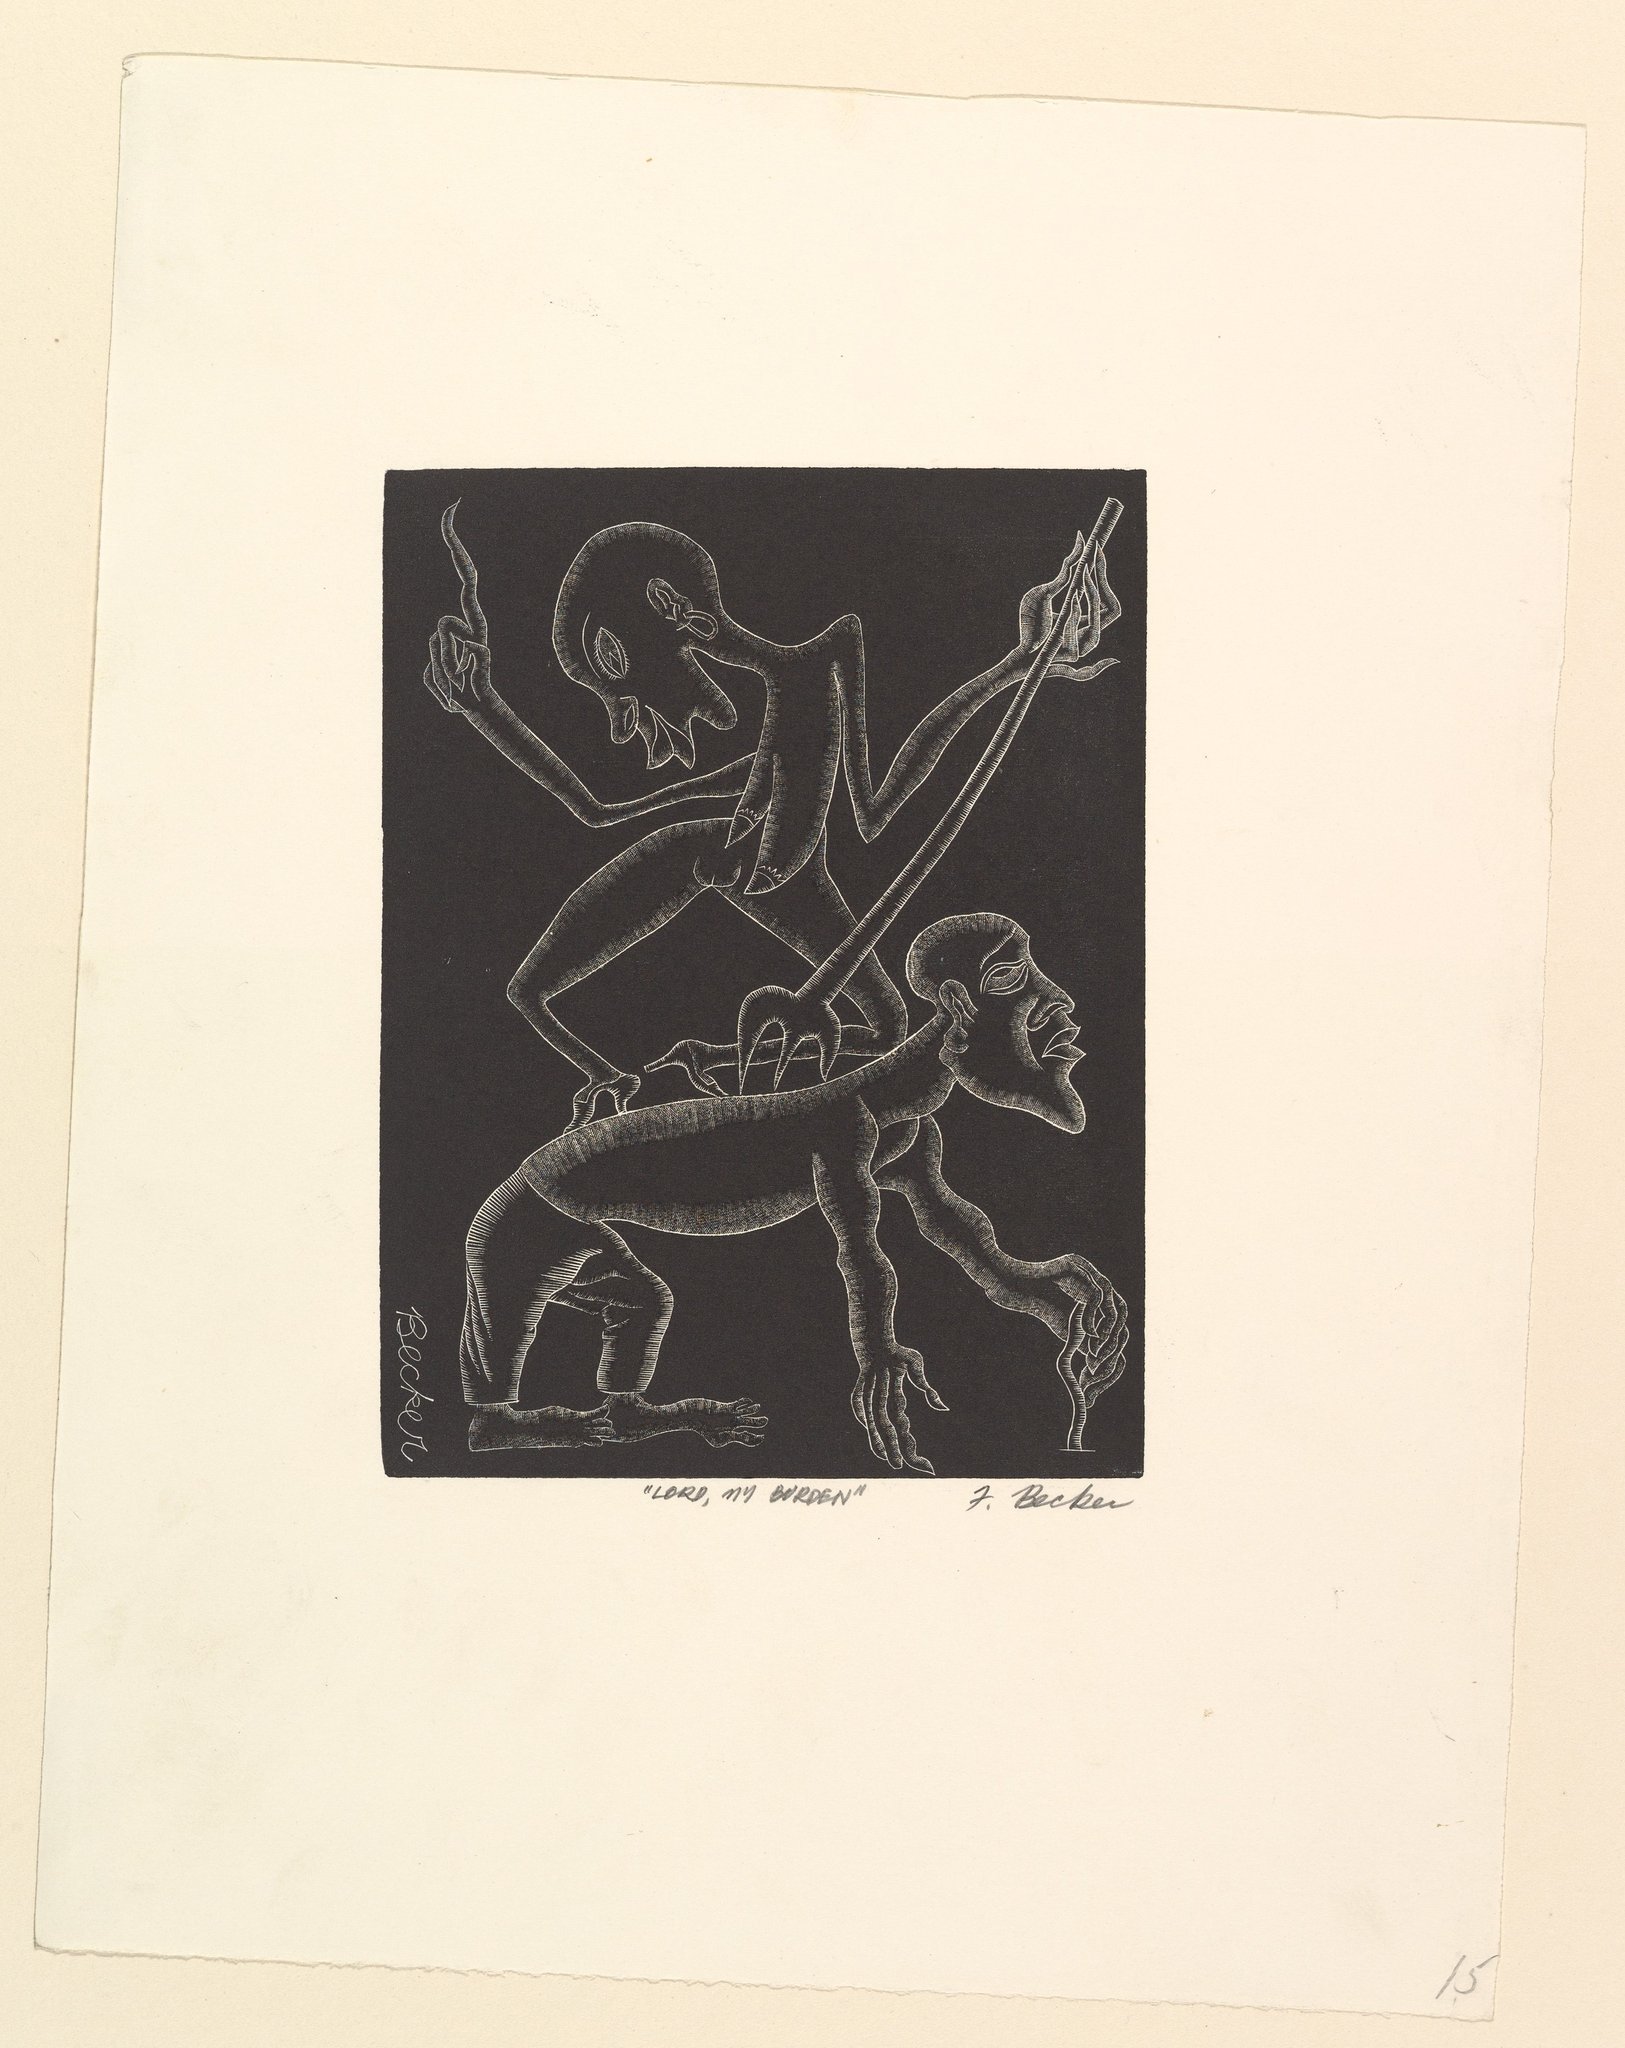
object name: print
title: Lord, My Burden!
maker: fred becker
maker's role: artist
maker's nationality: american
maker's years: 1913-2004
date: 1935-1940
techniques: engraving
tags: abstraction